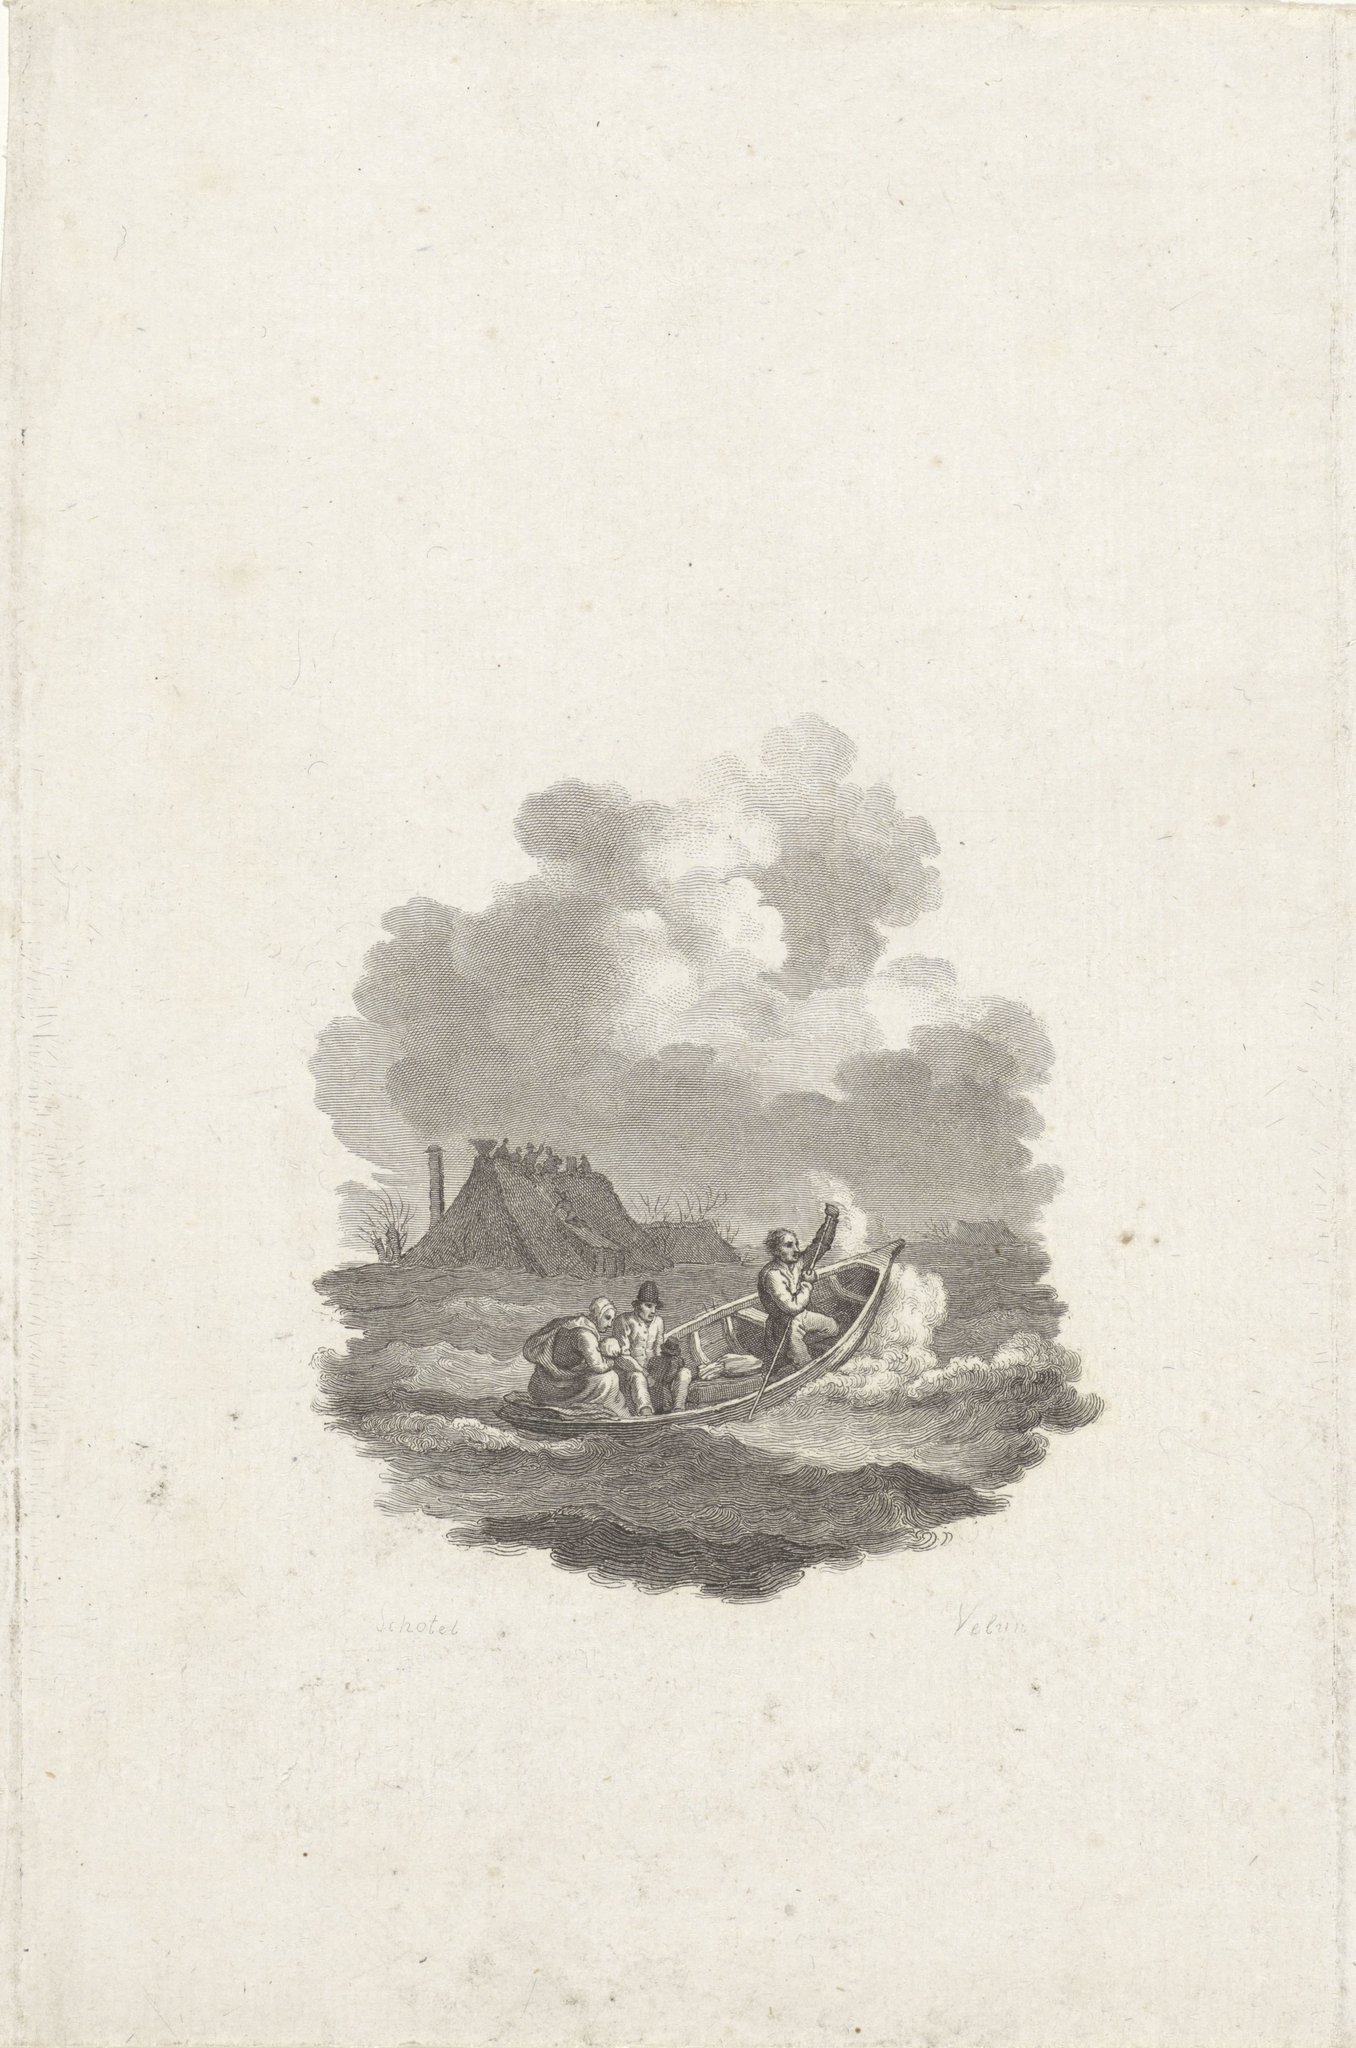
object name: print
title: Figuren in een boot tijdens een overstroming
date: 1797-1836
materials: paper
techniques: etching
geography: netherlands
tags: rescue work during a flood, roof (of house or building), rowing-boat, canoe, etc., flood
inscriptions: collector's mark: Lugt 2228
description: Figuren in een boot tijdens een overstroming. Op de achtergrond andere figuren op een dak, dat boven het water uitsteekt.